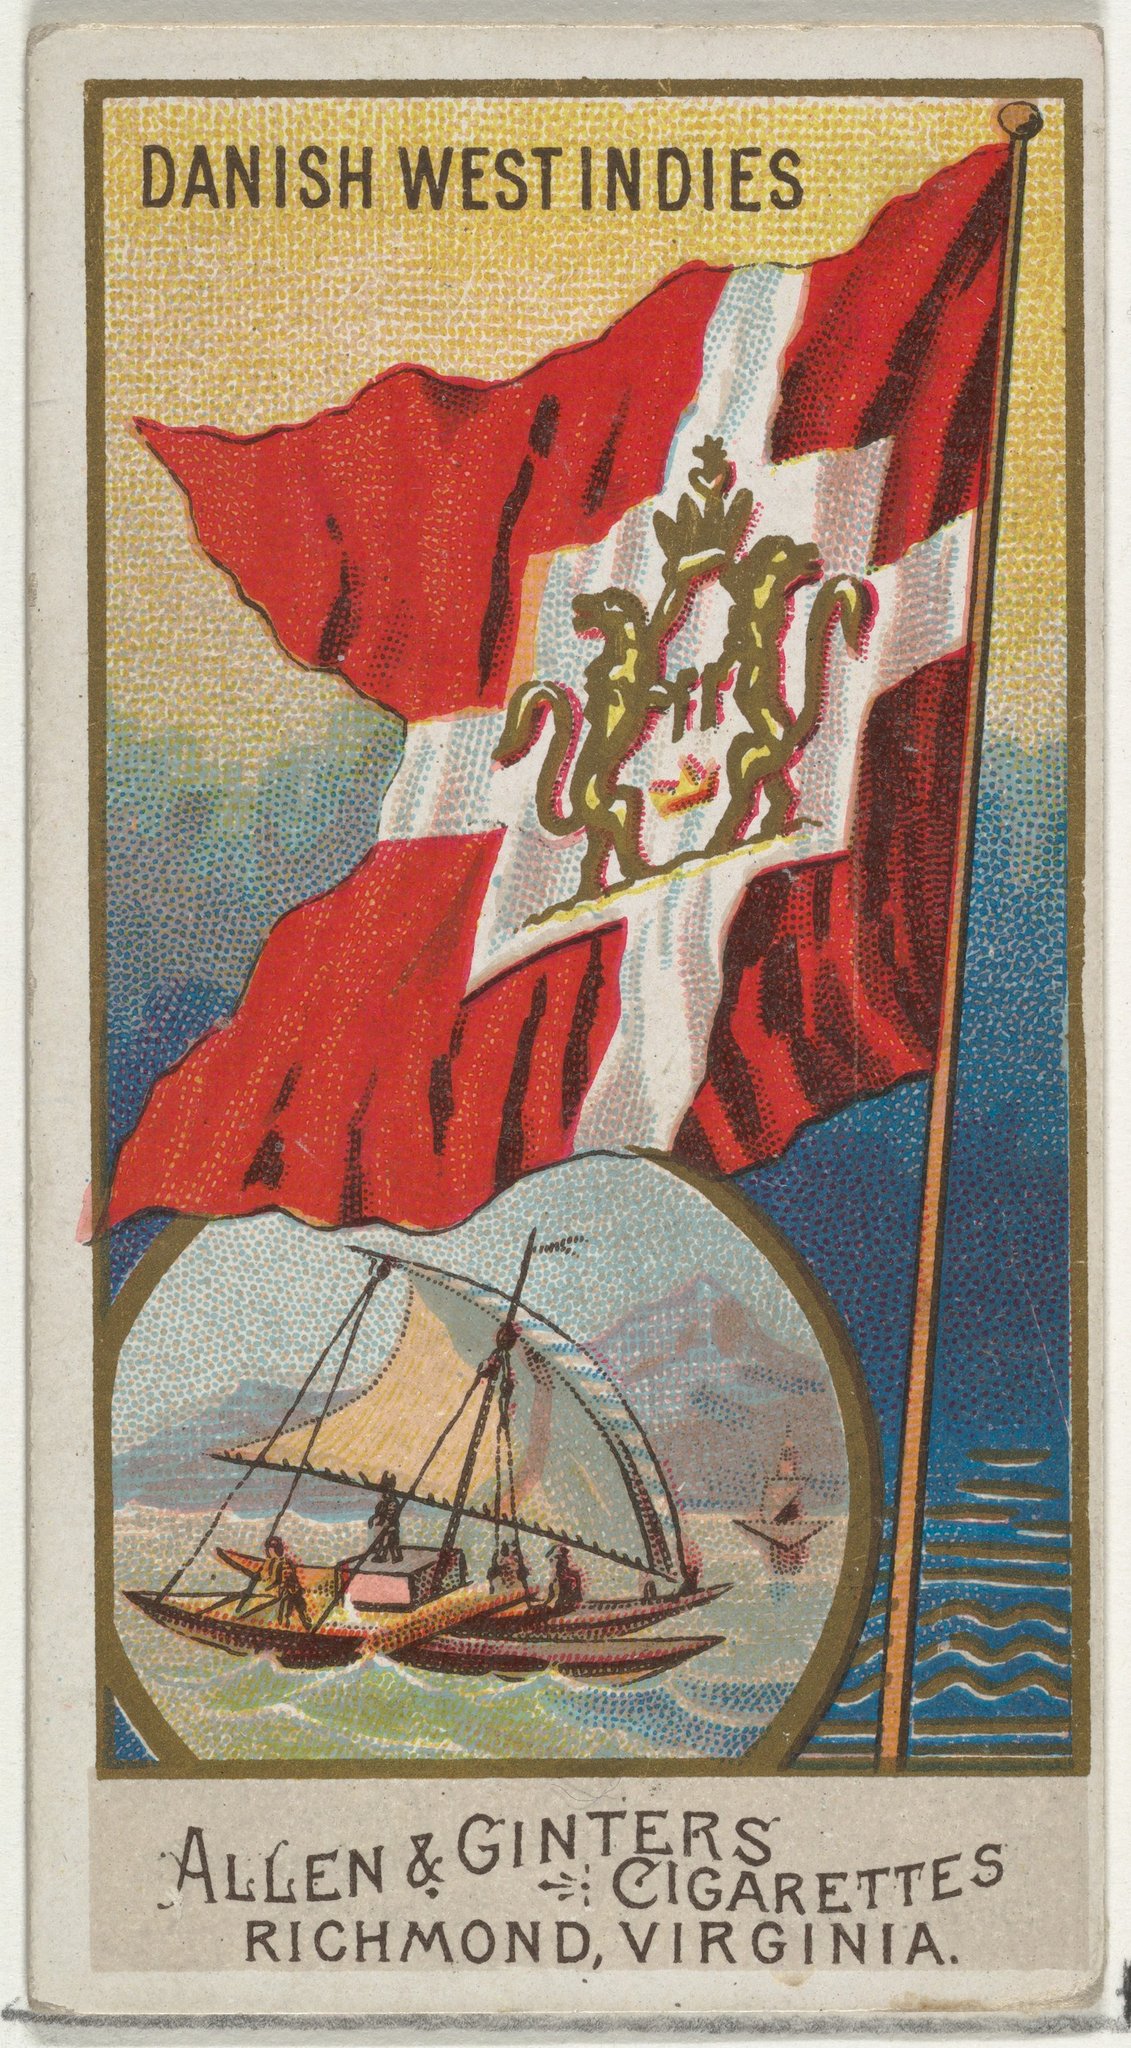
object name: print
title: Danish West Indies, from Flags of All Nations, Series 2 (N10) for Allen & Ginter Cigarettes Brands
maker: allen & ginter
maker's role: publisher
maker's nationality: american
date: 1890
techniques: color lithograph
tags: coat of arms,flags